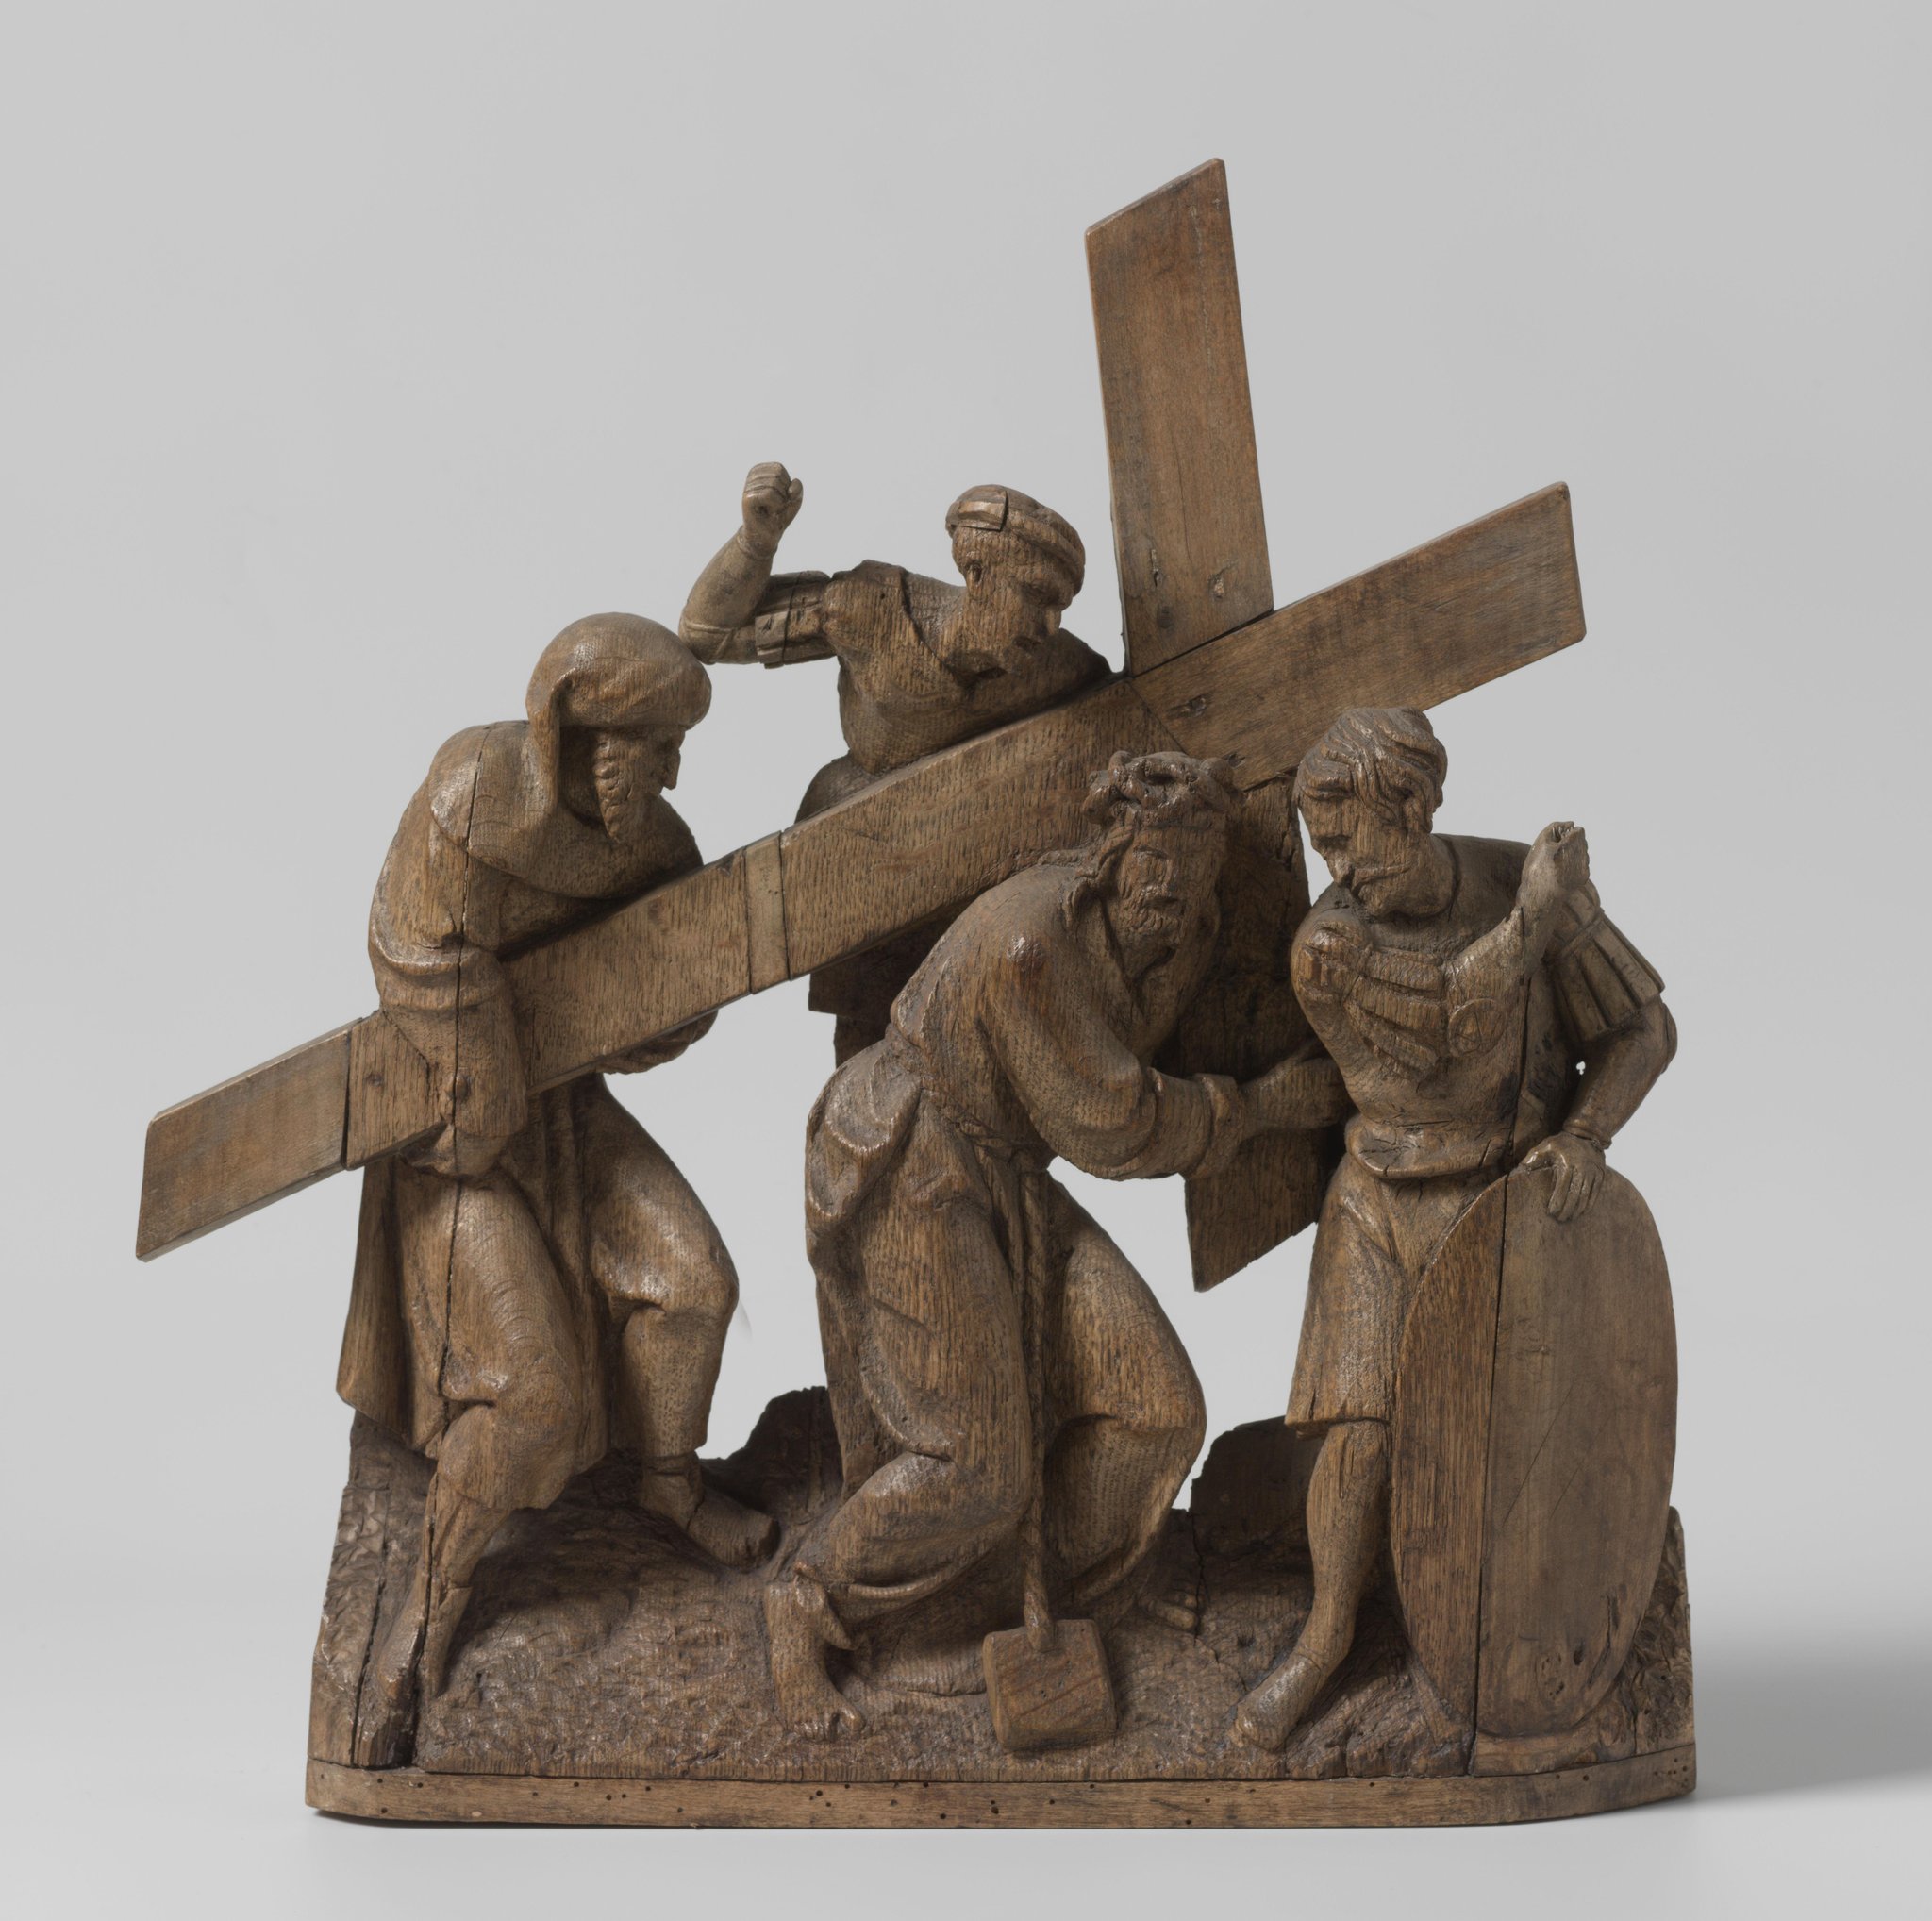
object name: sculpture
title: Christ Carrying the Cross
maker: Anonymous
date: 1540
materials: wood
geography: antwerp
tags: carrying of the cross: christ bearing the cross, alone or with the help of others (e.g. simon the cyrenian)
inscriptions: inscription, on the reverse, in white paint: ‘KU 1230’